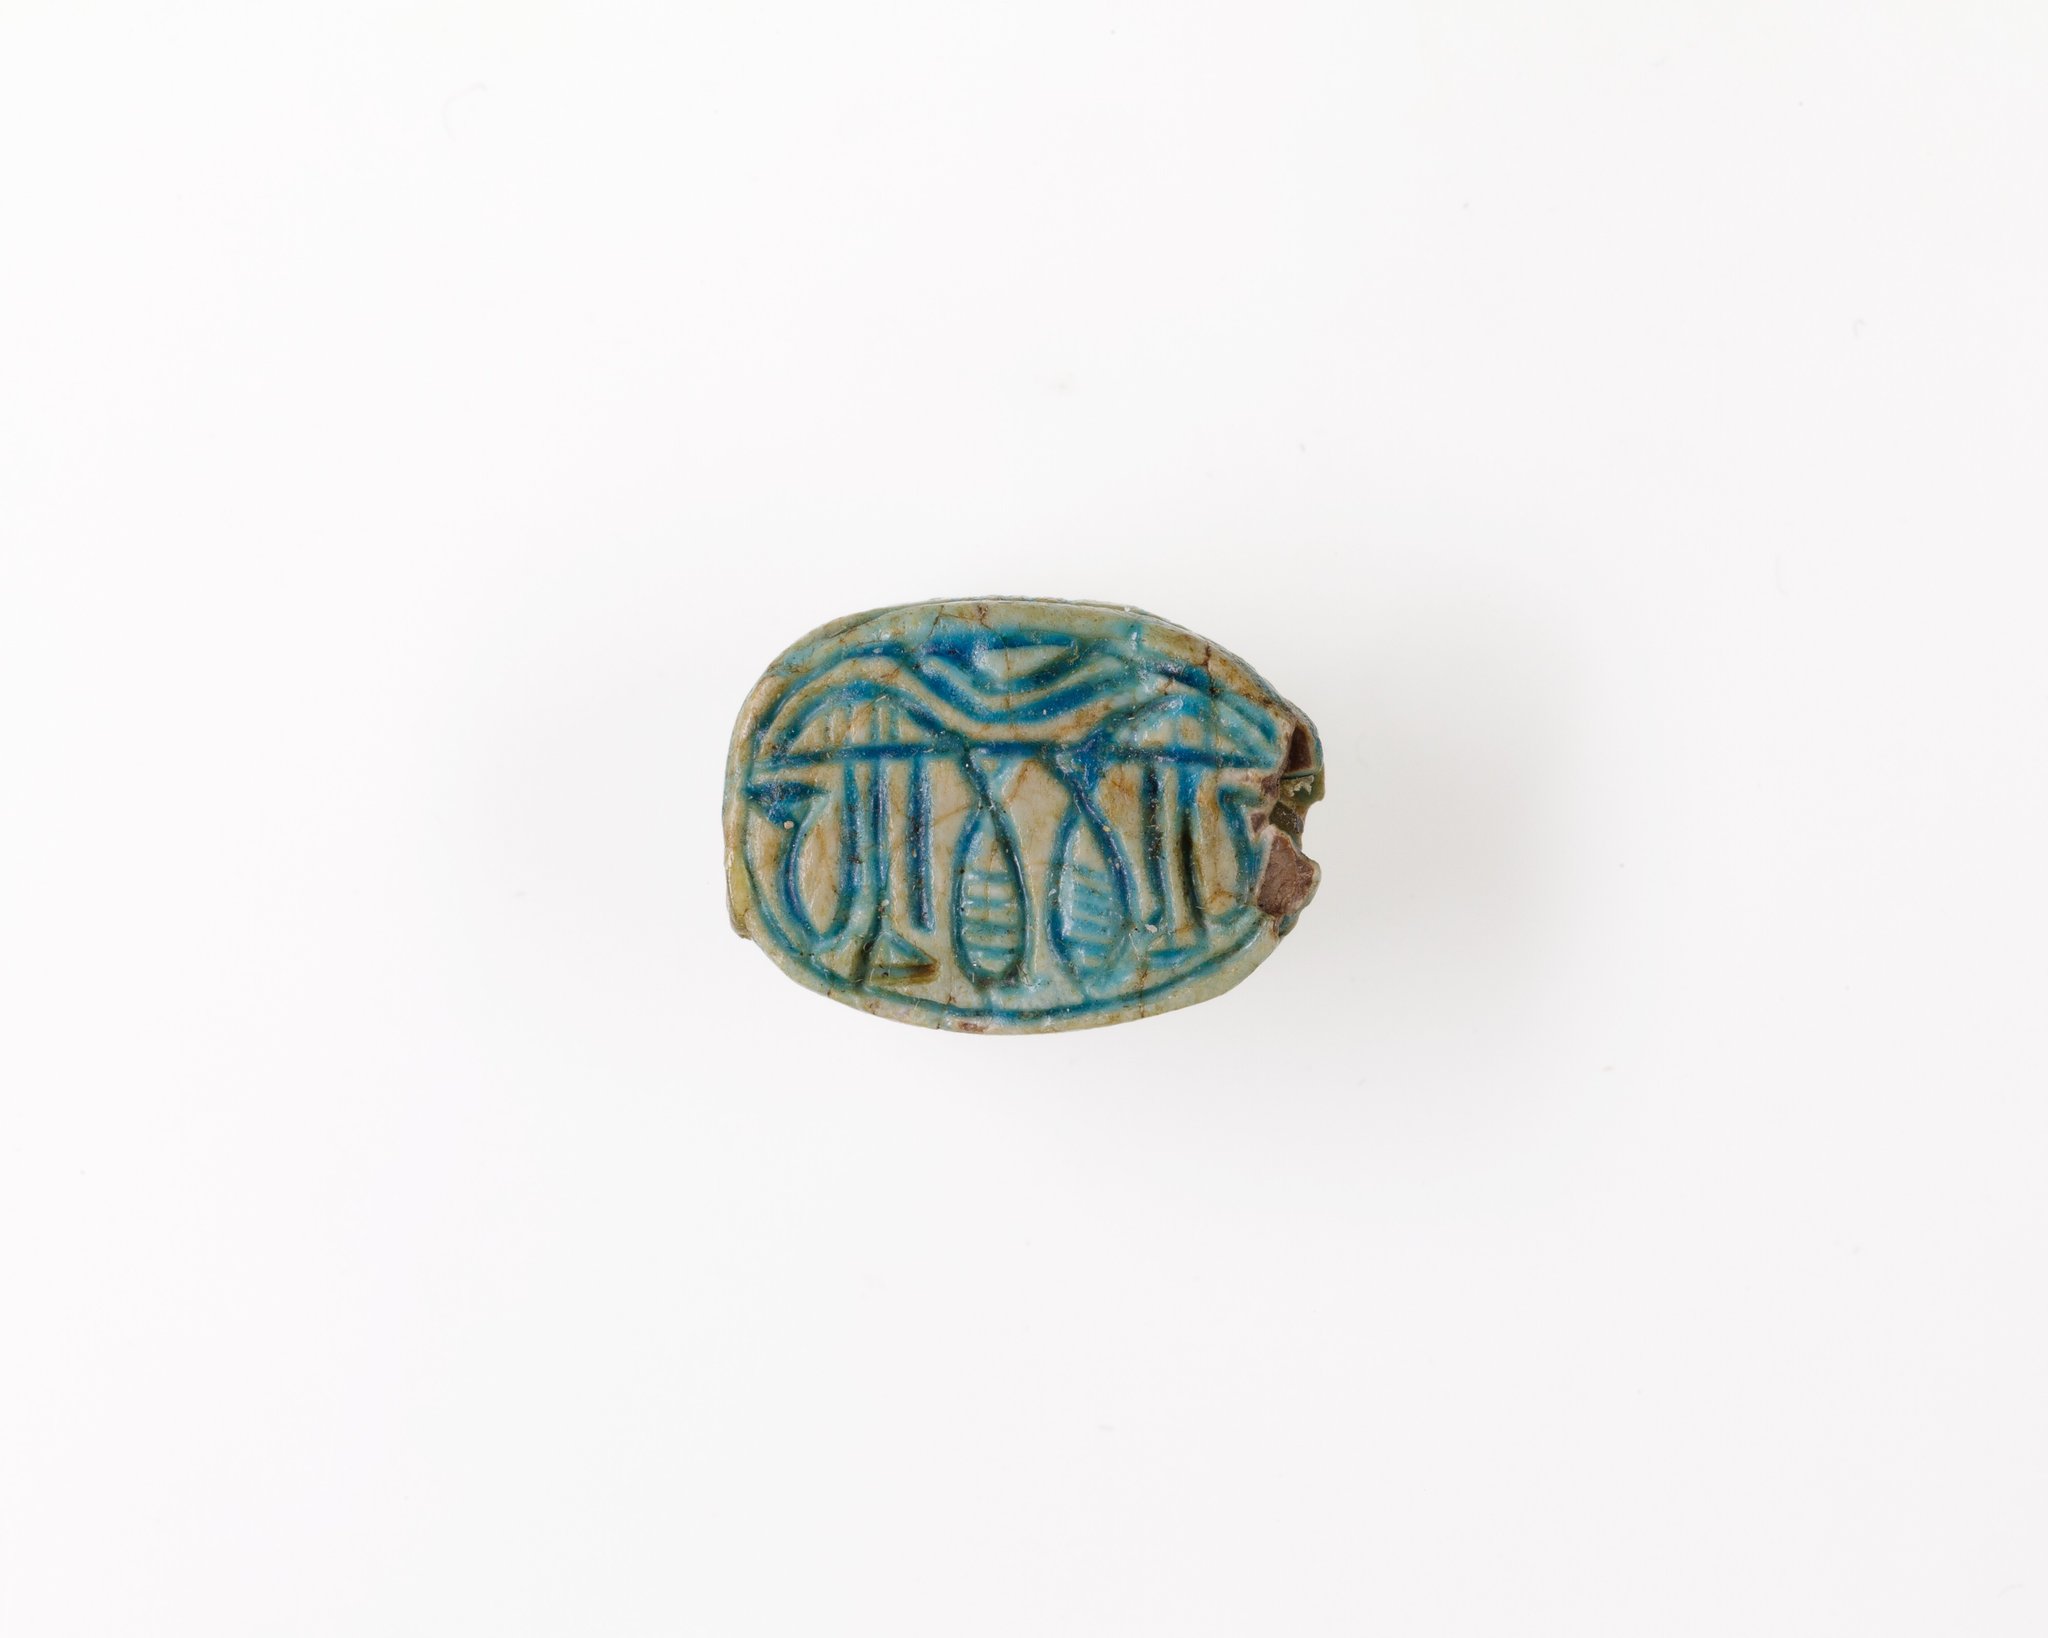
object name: scarab, papyrus, sa hieroglyph, nb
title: Scarab with Papyrus Plants and Signs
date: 1740-1640 BCE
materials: stone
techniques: glazing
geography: egypt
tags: hieroglyphs,scarabs